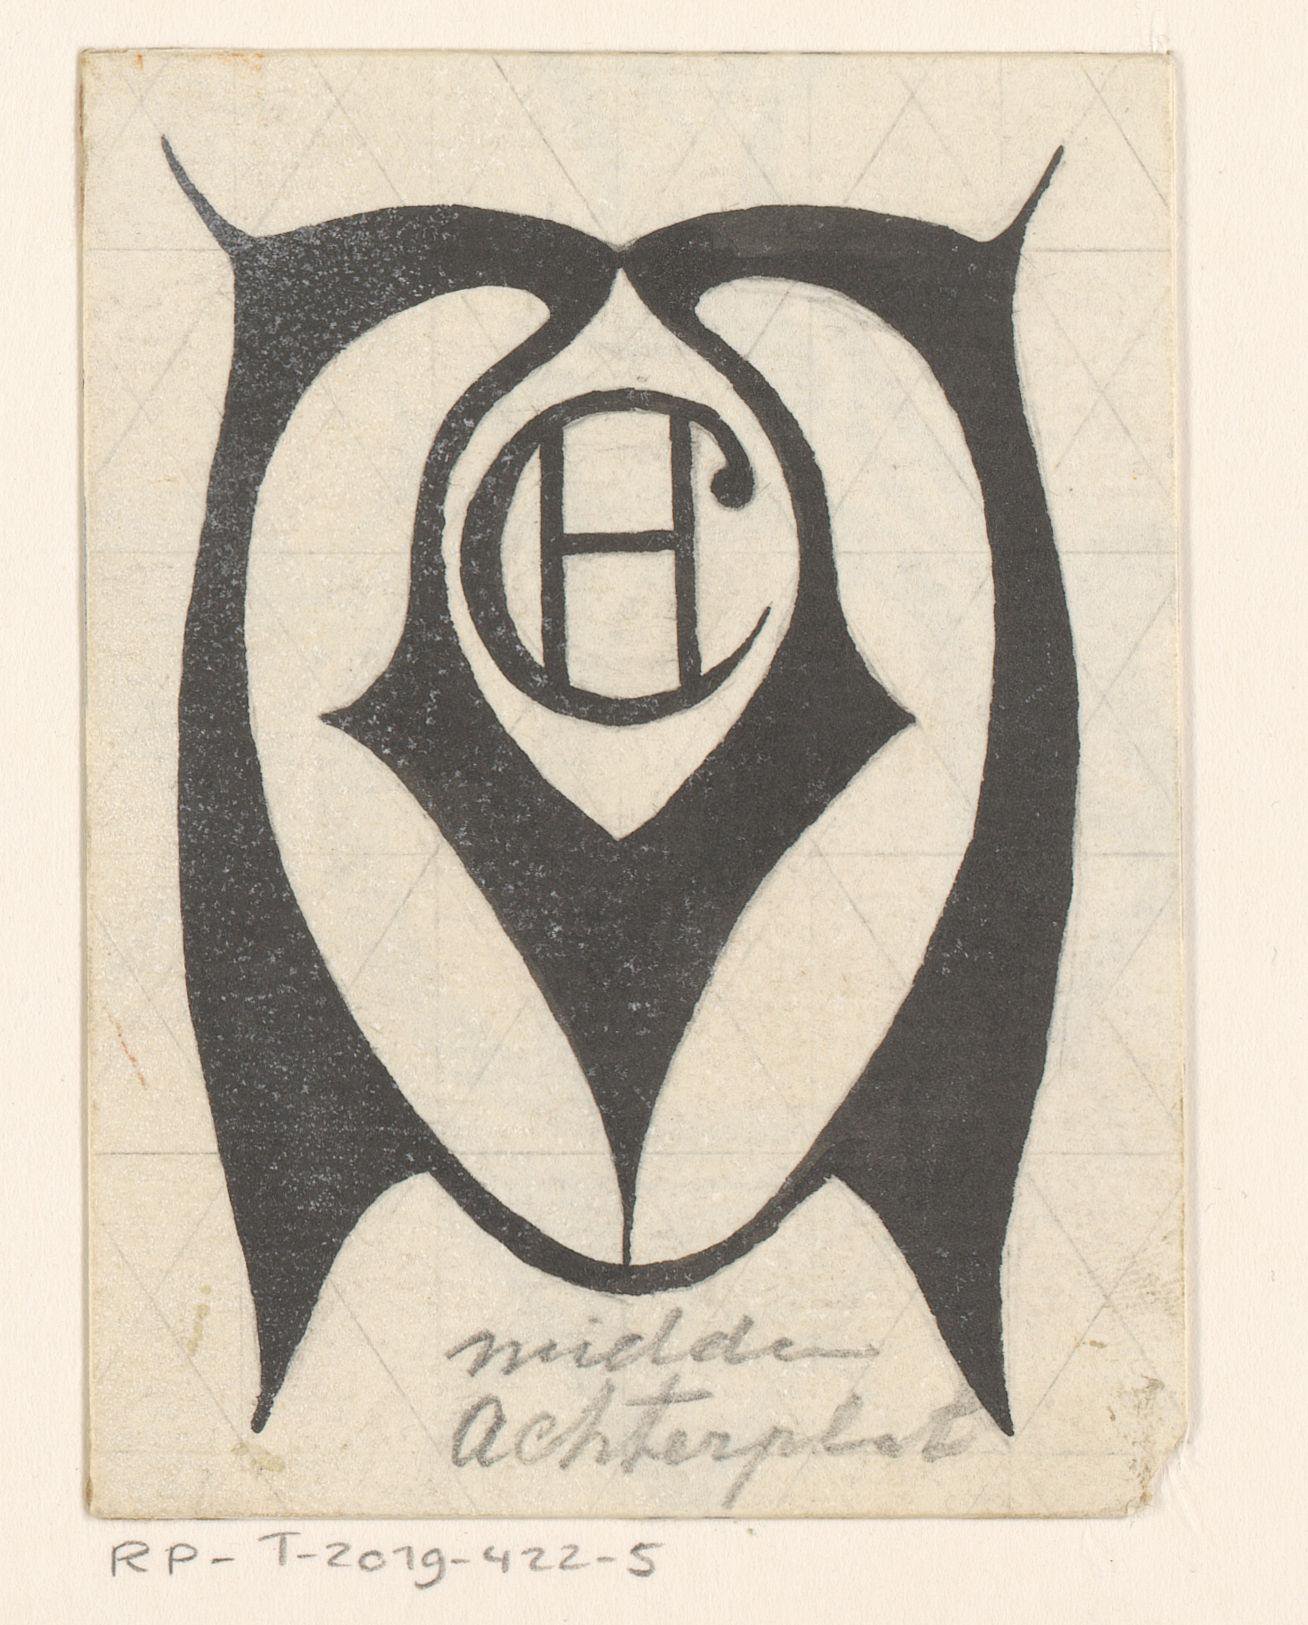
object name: study for binding design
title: Bandontwerp voor: Cornélie Huygens, Barthold Meryan, 1899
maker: richard nicolaüs roland holst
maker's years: 1868-1938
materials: ink, paper, pencil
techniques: brush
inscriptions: collector's mark: Lugt 2228, annotation: ‘midden/ achterplat’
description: Bandontwerp met de initialen C en H (de initialen van de auteur), bedoeld voor de achterzijde van de band.